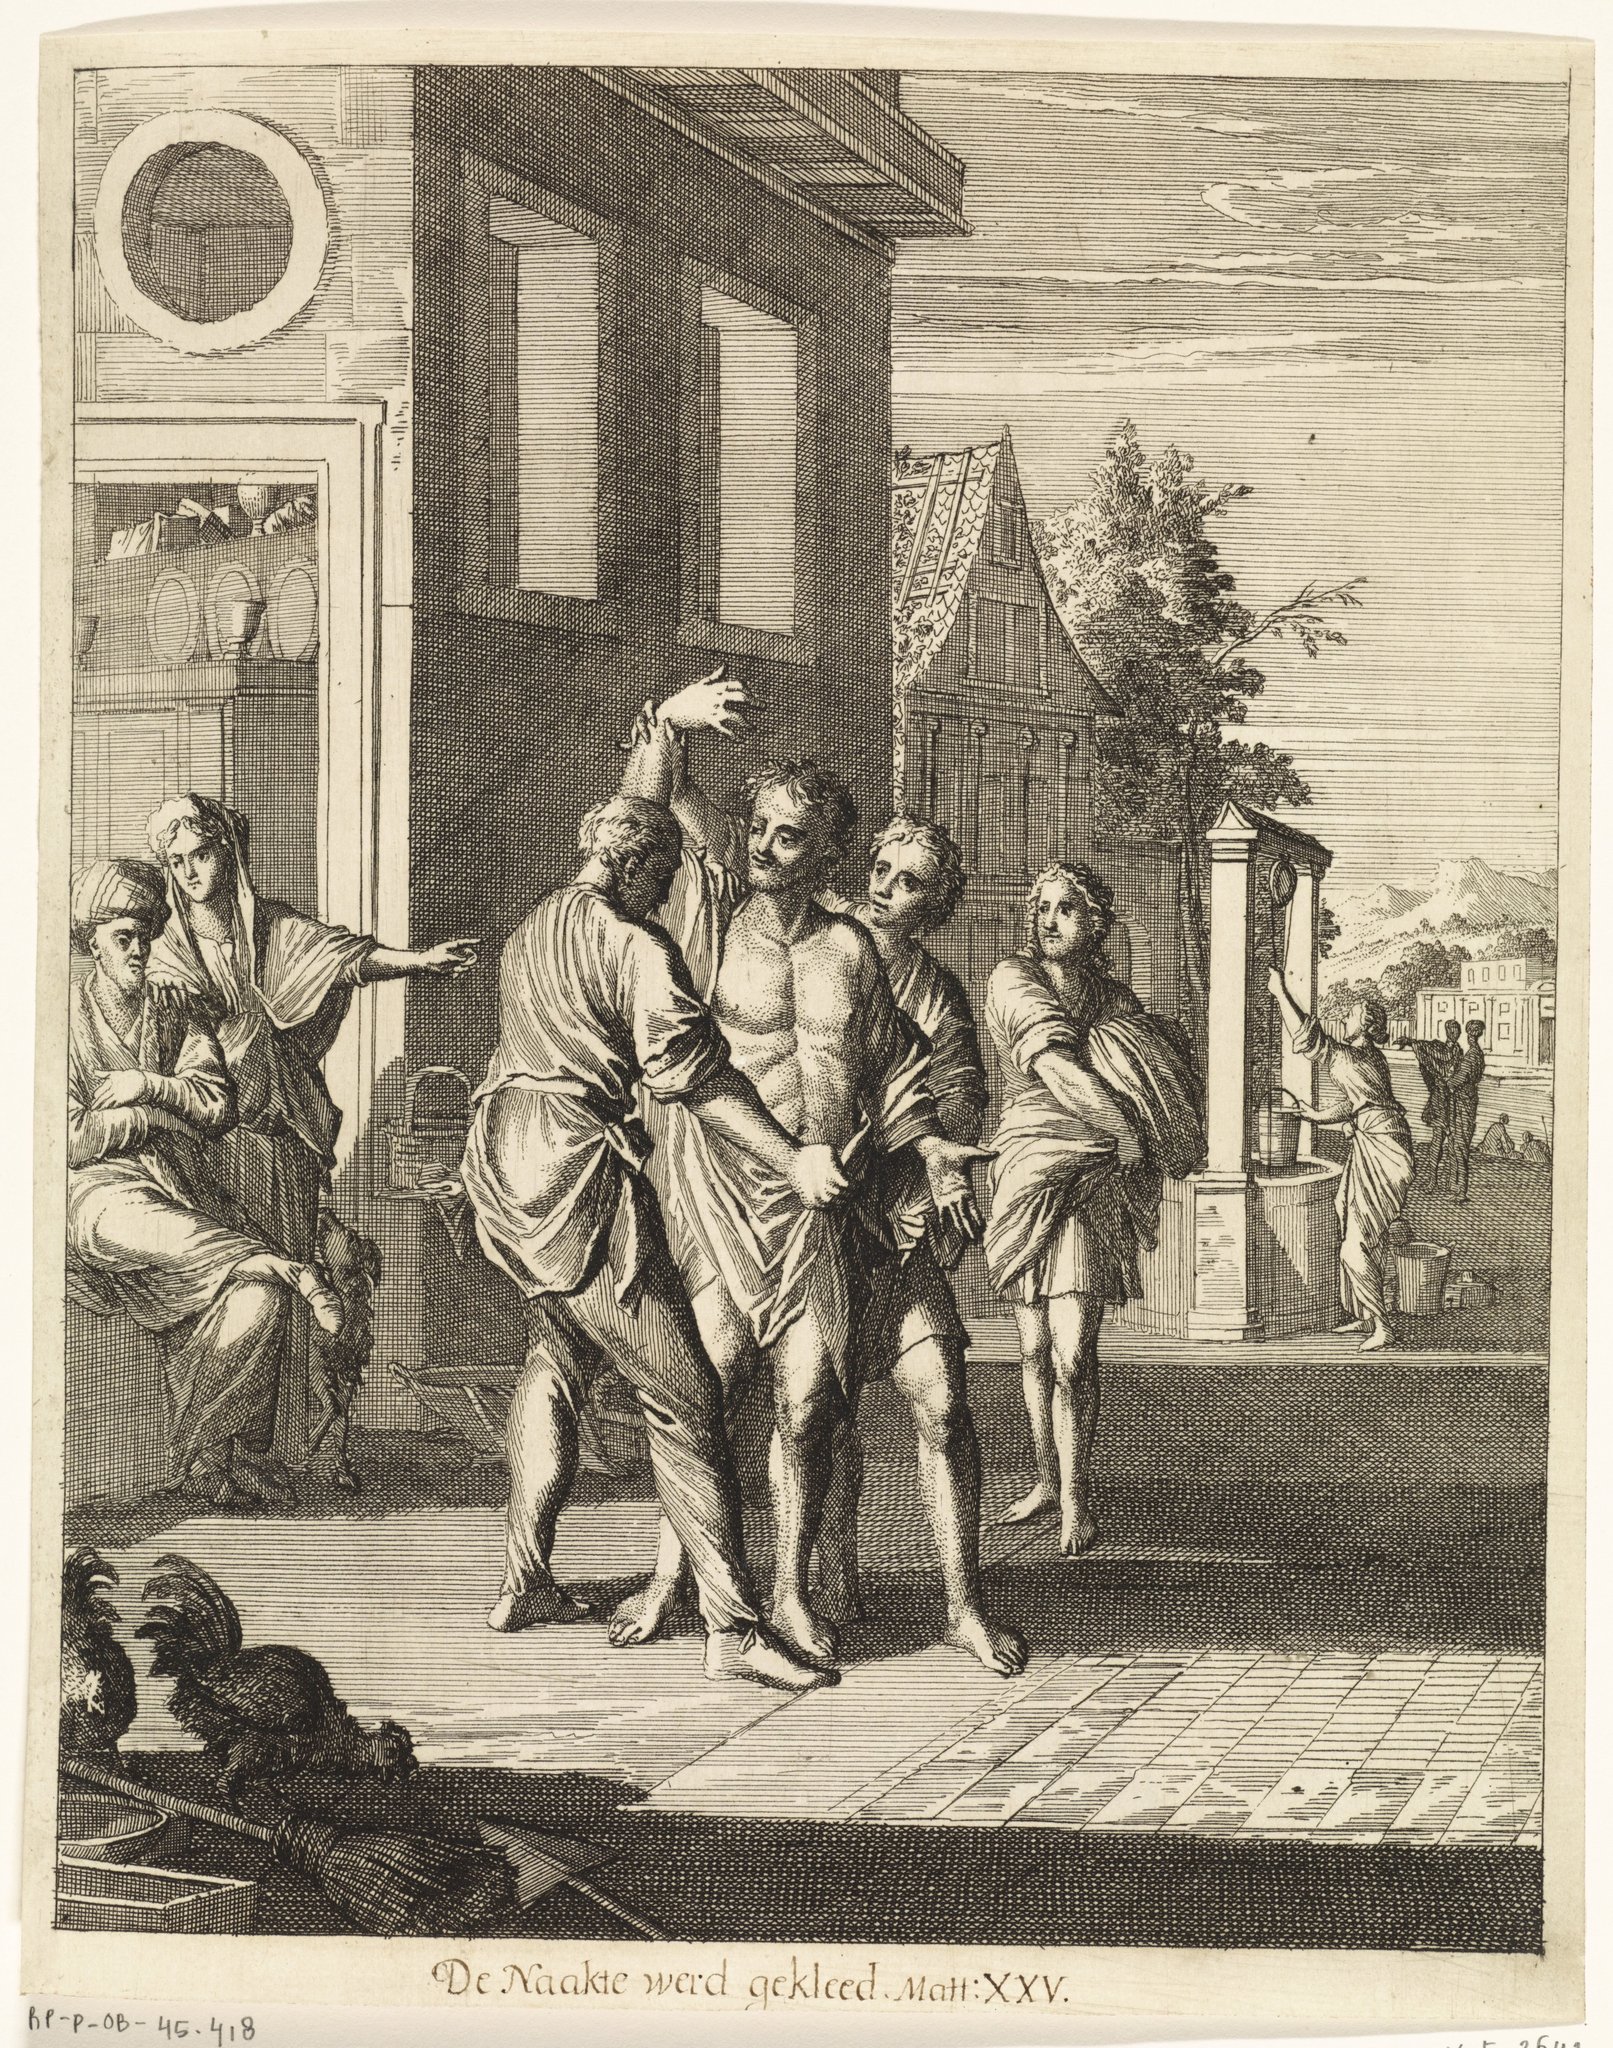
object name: print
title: Naakten kleden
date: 1708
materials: paper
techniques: etching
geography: nuremberg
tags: clothing the naked, 'nudus vestitur' ~ one of the (seven) acts of mercy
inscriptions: collector's mark: Lugt 2228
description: Proefdruk van een prent welke is opgenomen als illustratie in: Historiae Celebriores Veteris Testamenti. Christoph Weigel, 1708.